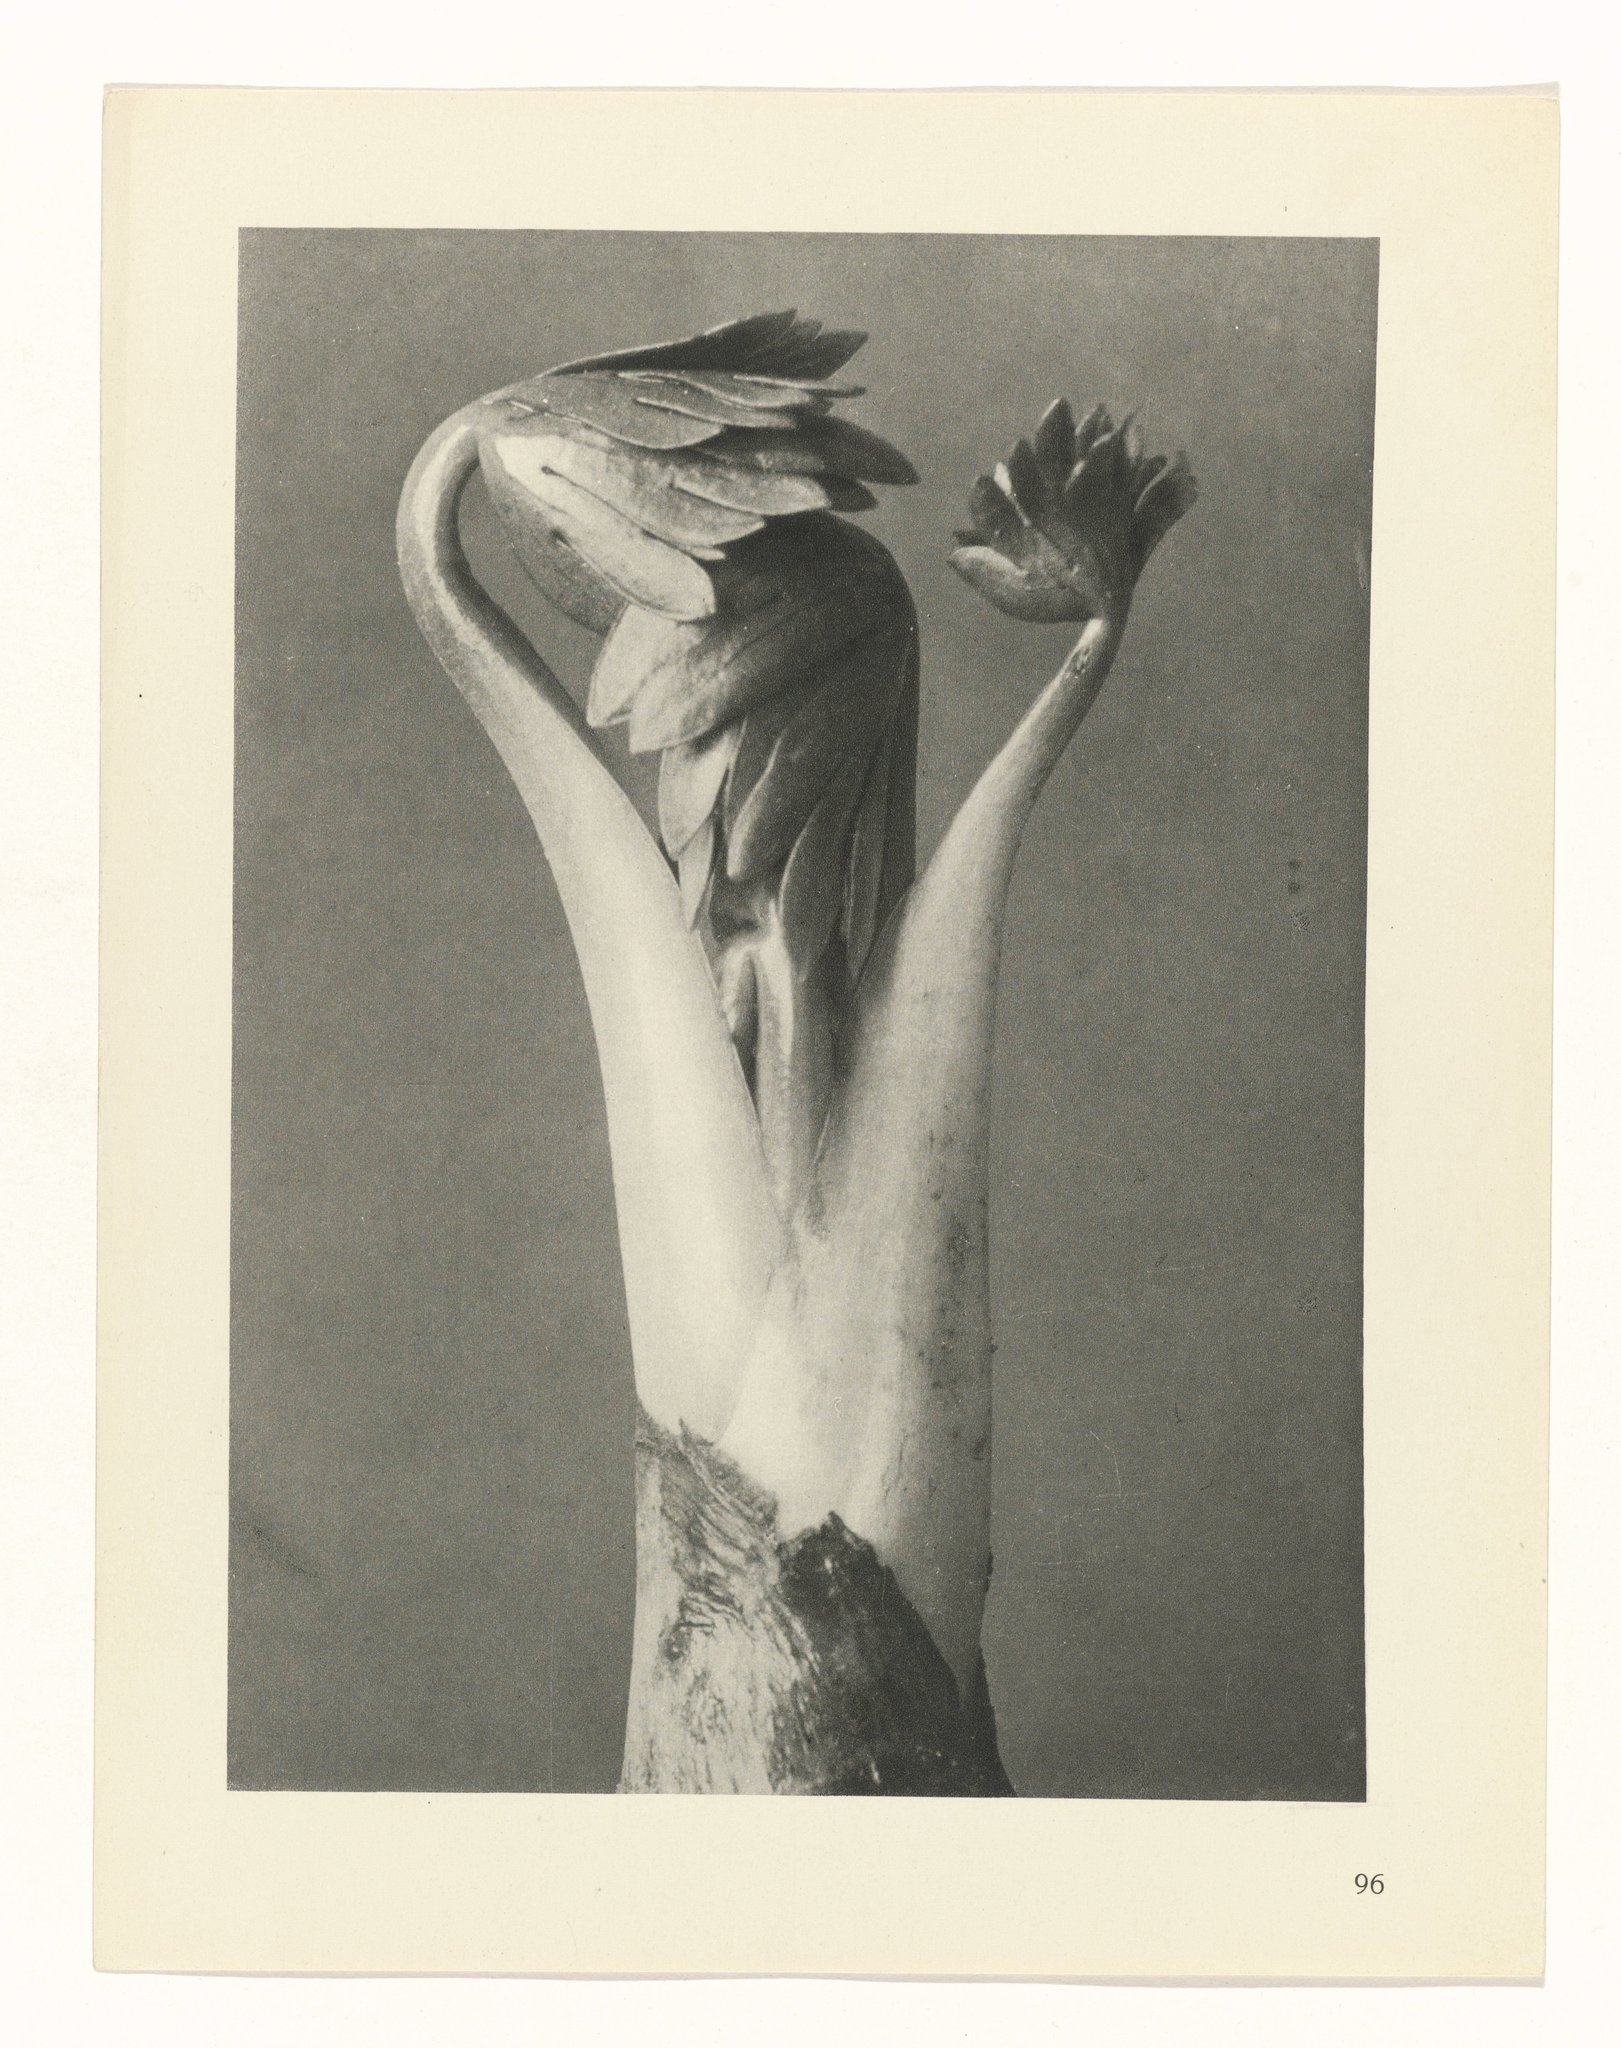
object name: photograph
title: Plantstudie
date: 1928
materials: ink, paper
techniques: rotogravure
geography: berlin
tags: plants (in general)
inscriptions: number: ‘96’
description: facher Vergrößerung. Afkomstig uit losbladige uitgave.